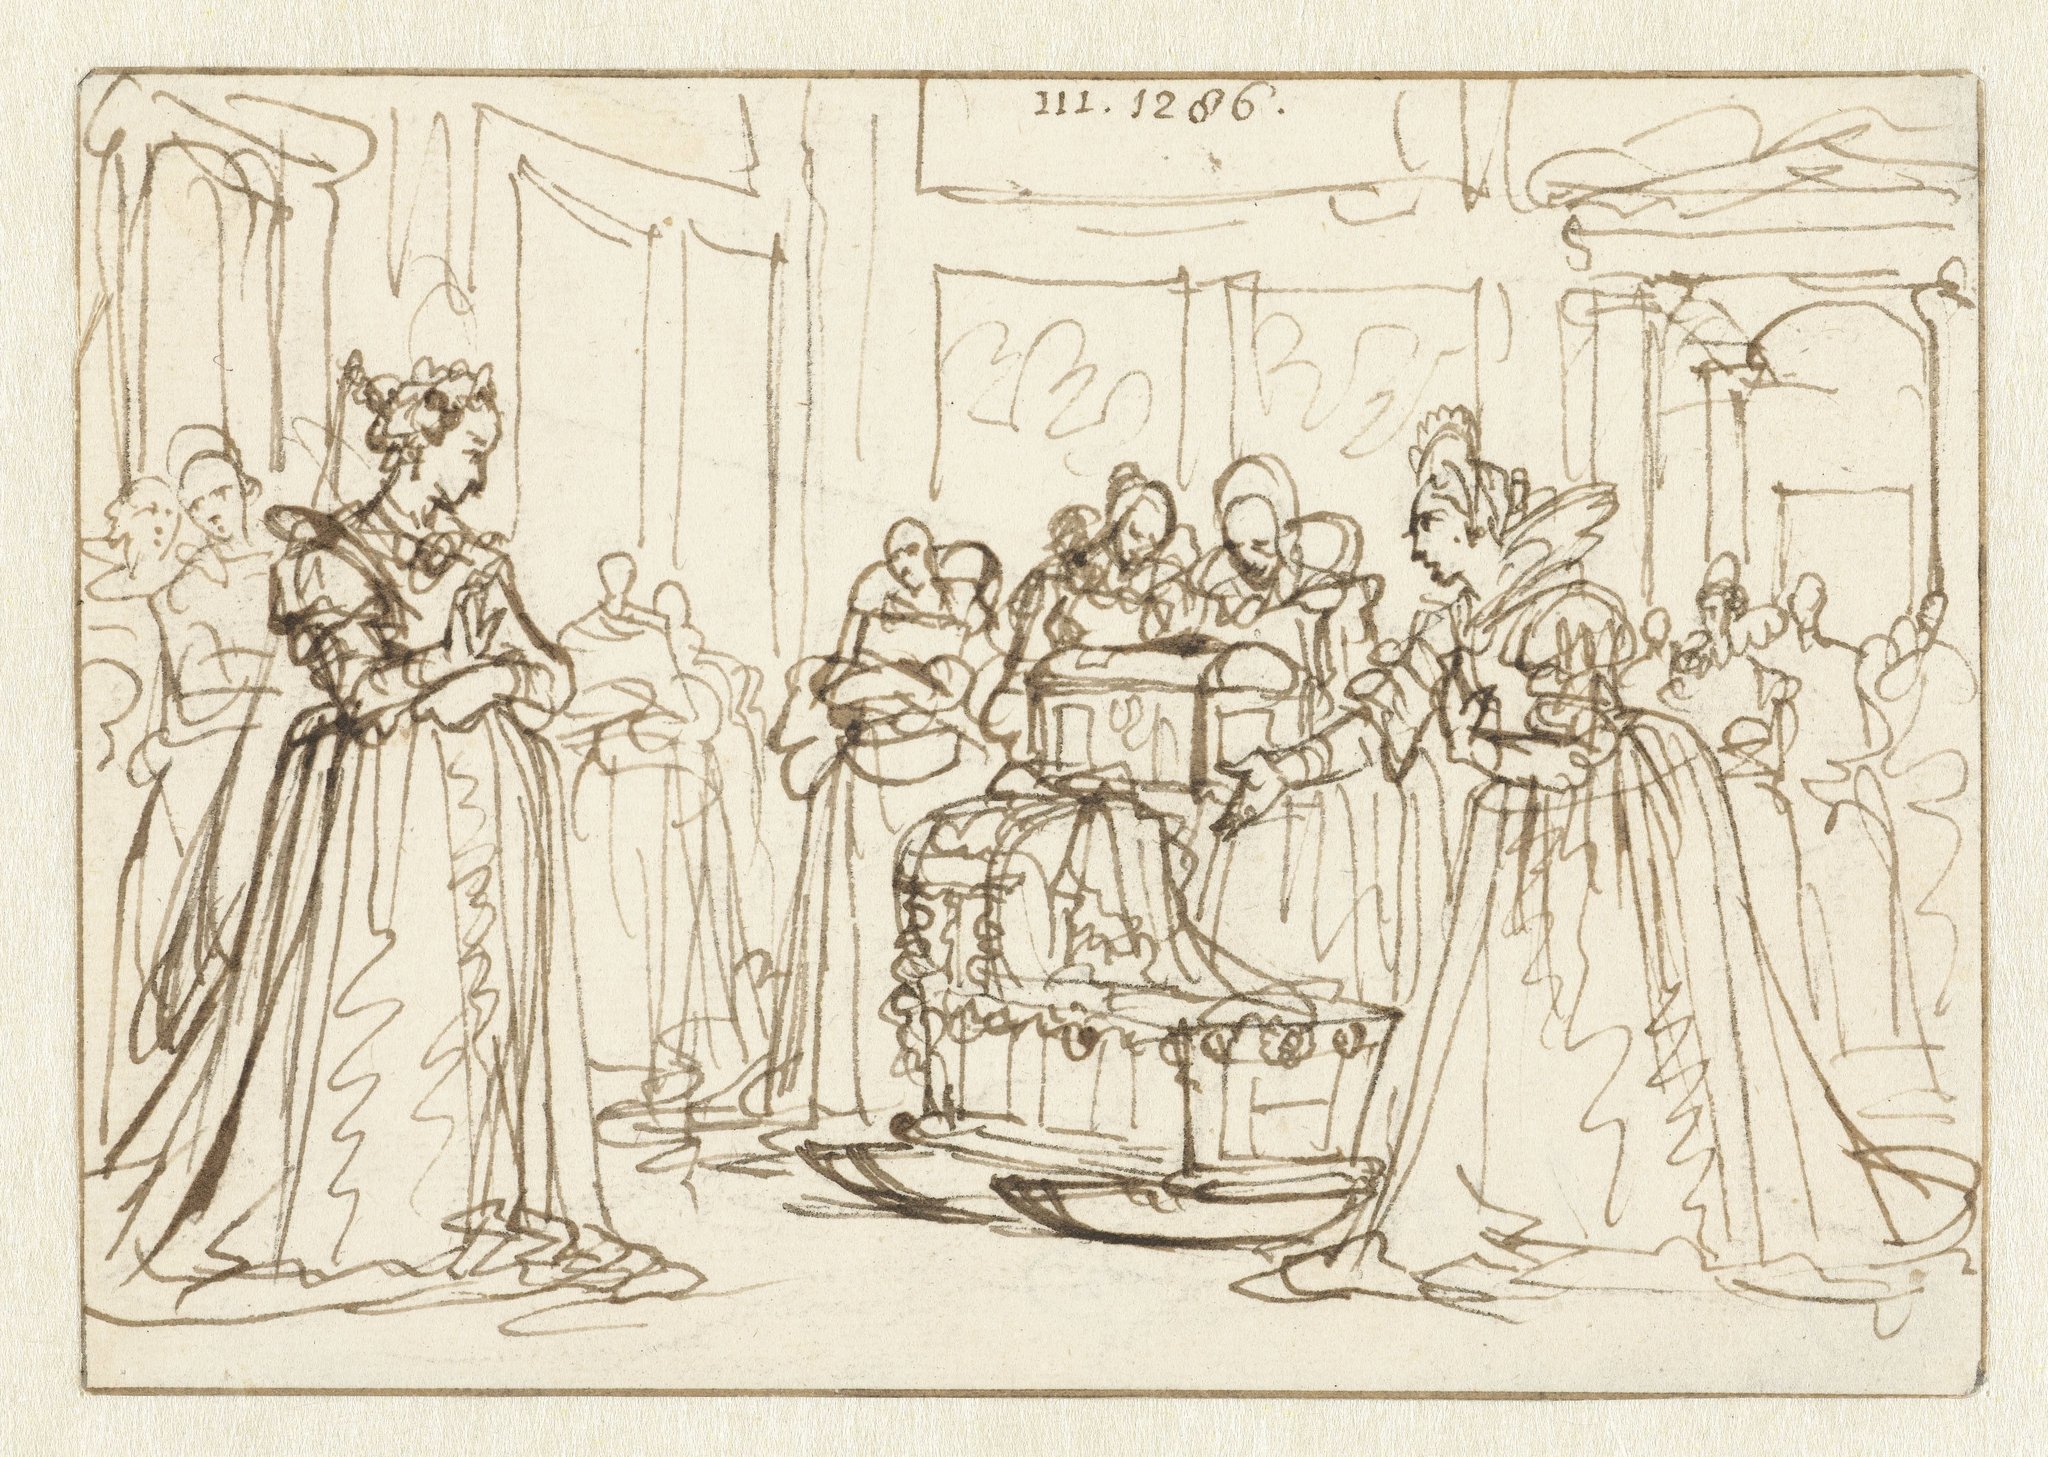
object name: design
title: Koningin van Bohemen krijgt geschenken van vrouwen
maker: caspar luyken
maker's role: draughtsman, print maker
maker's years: 1672-1708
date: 1682-1708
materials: ink, paper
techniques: pen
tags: historical persons, cradle, crib, bringing gifts; exchanging gifts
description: De koningin van Bohemen krijgt geschenken aangeboden door voorname vrouwen van drie Prager steden. Mogelijk een ontwerp voor een prent.